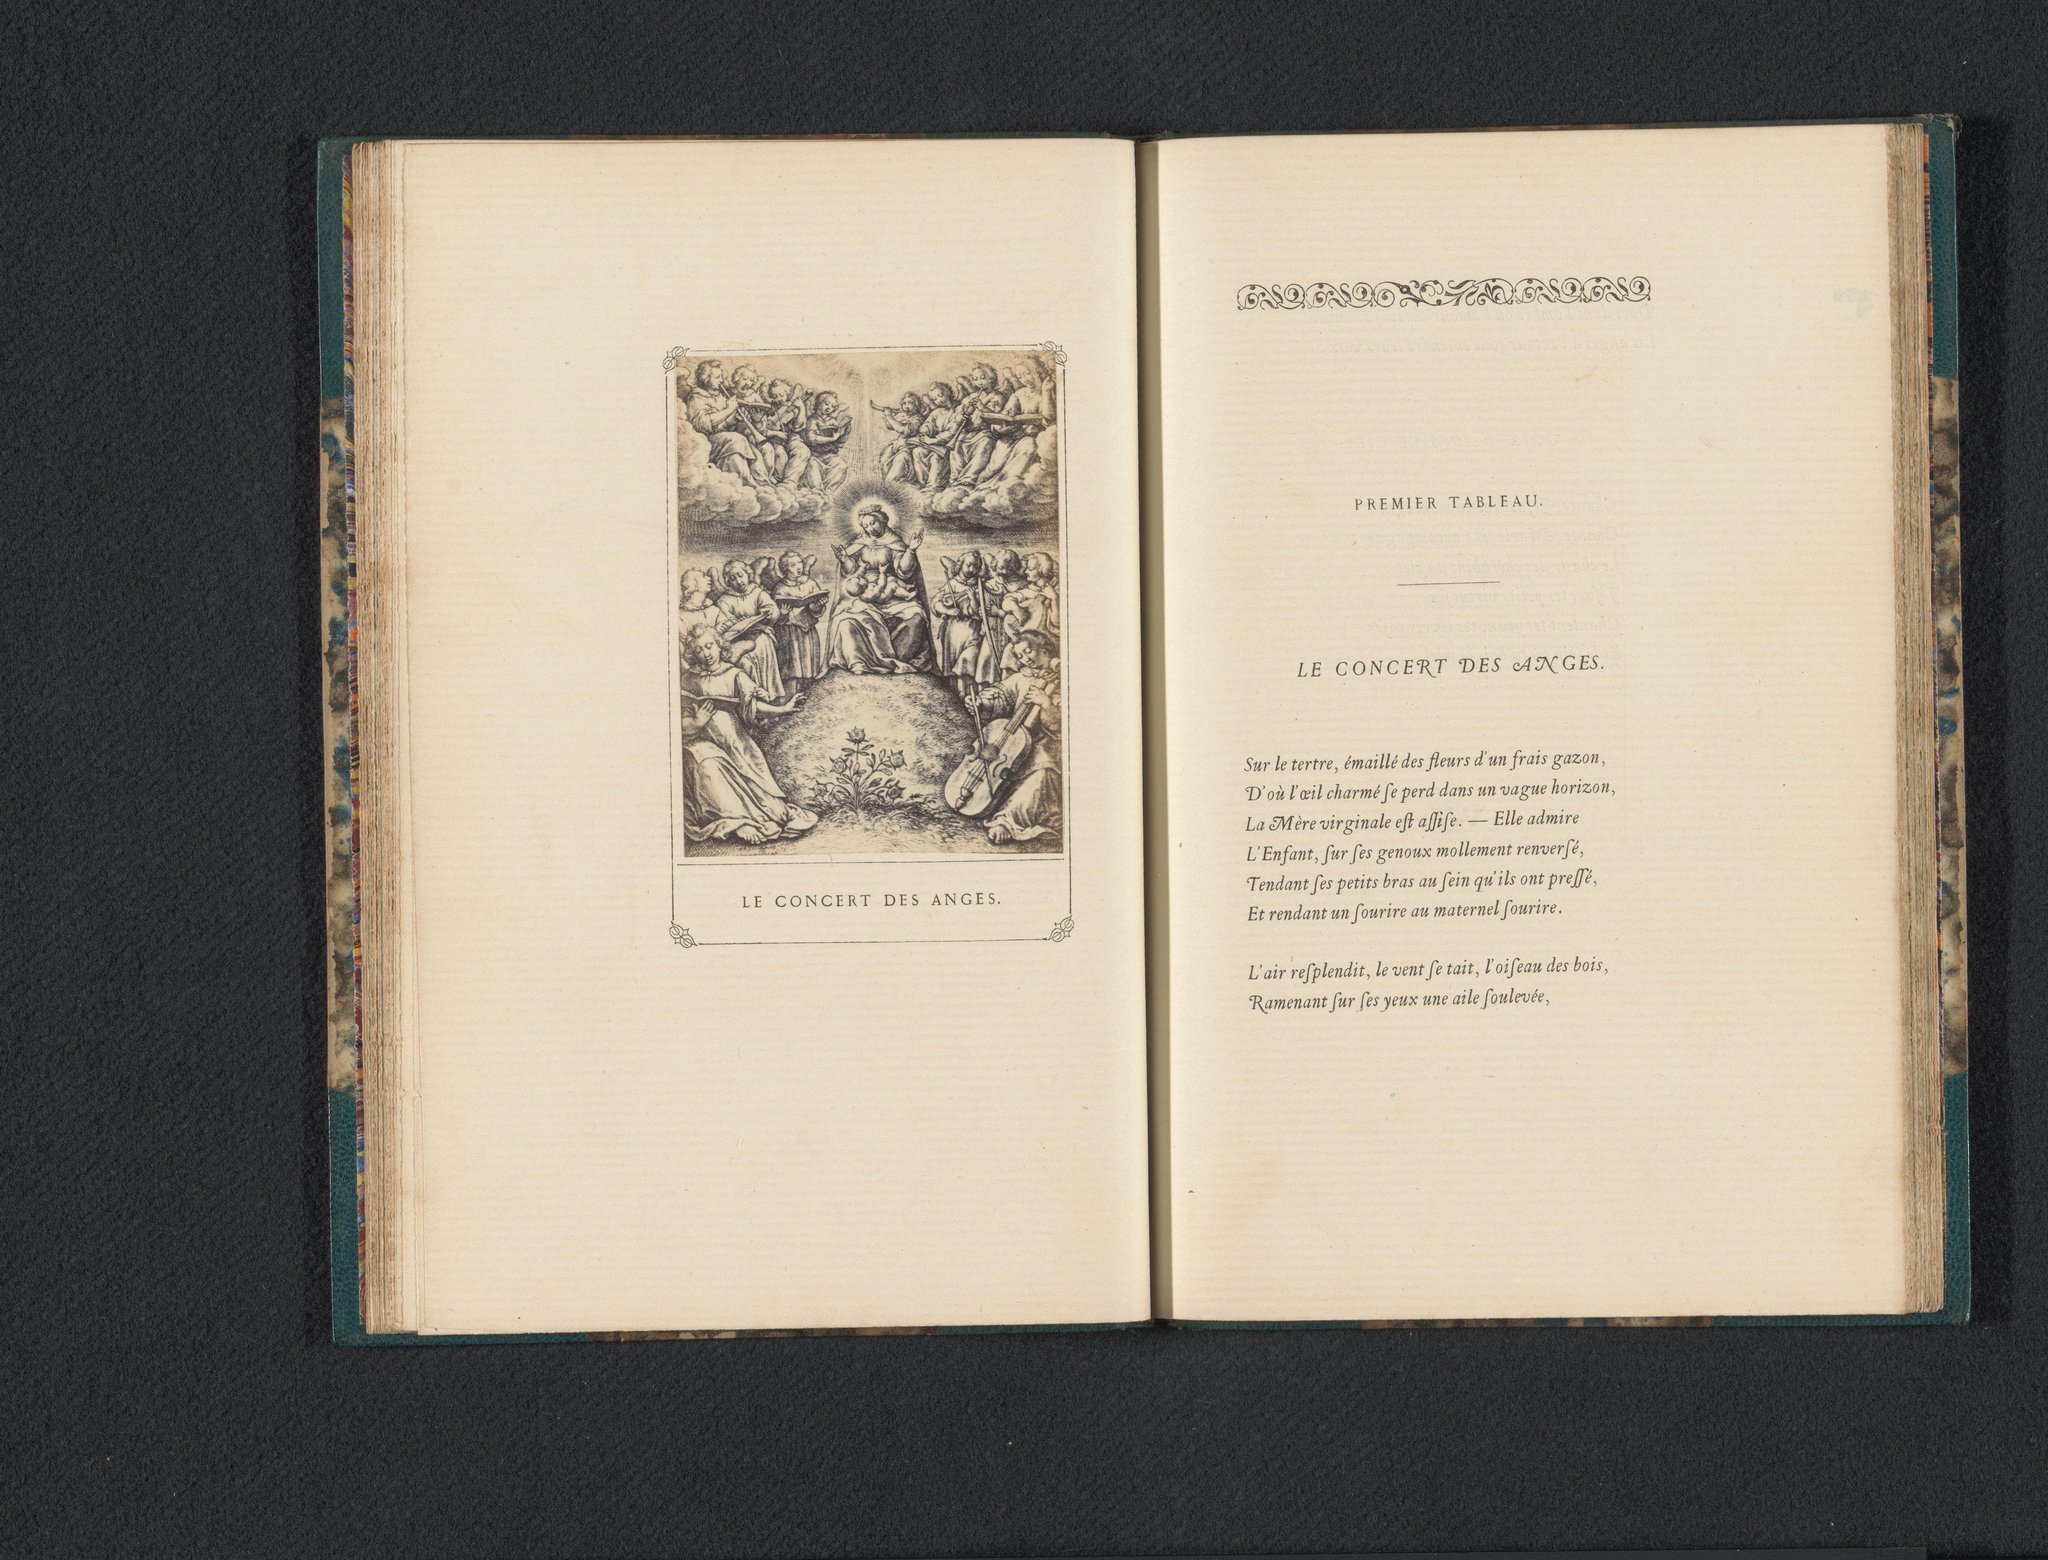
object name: reproduction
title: Fotoreproductie van Le Concert des Anges door Edmond Fierlants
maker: edmond fierlants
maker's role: fotograaf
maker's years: 1819-1869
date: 1855-1860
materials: photographic support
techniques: albumen print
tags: angels singing, making music